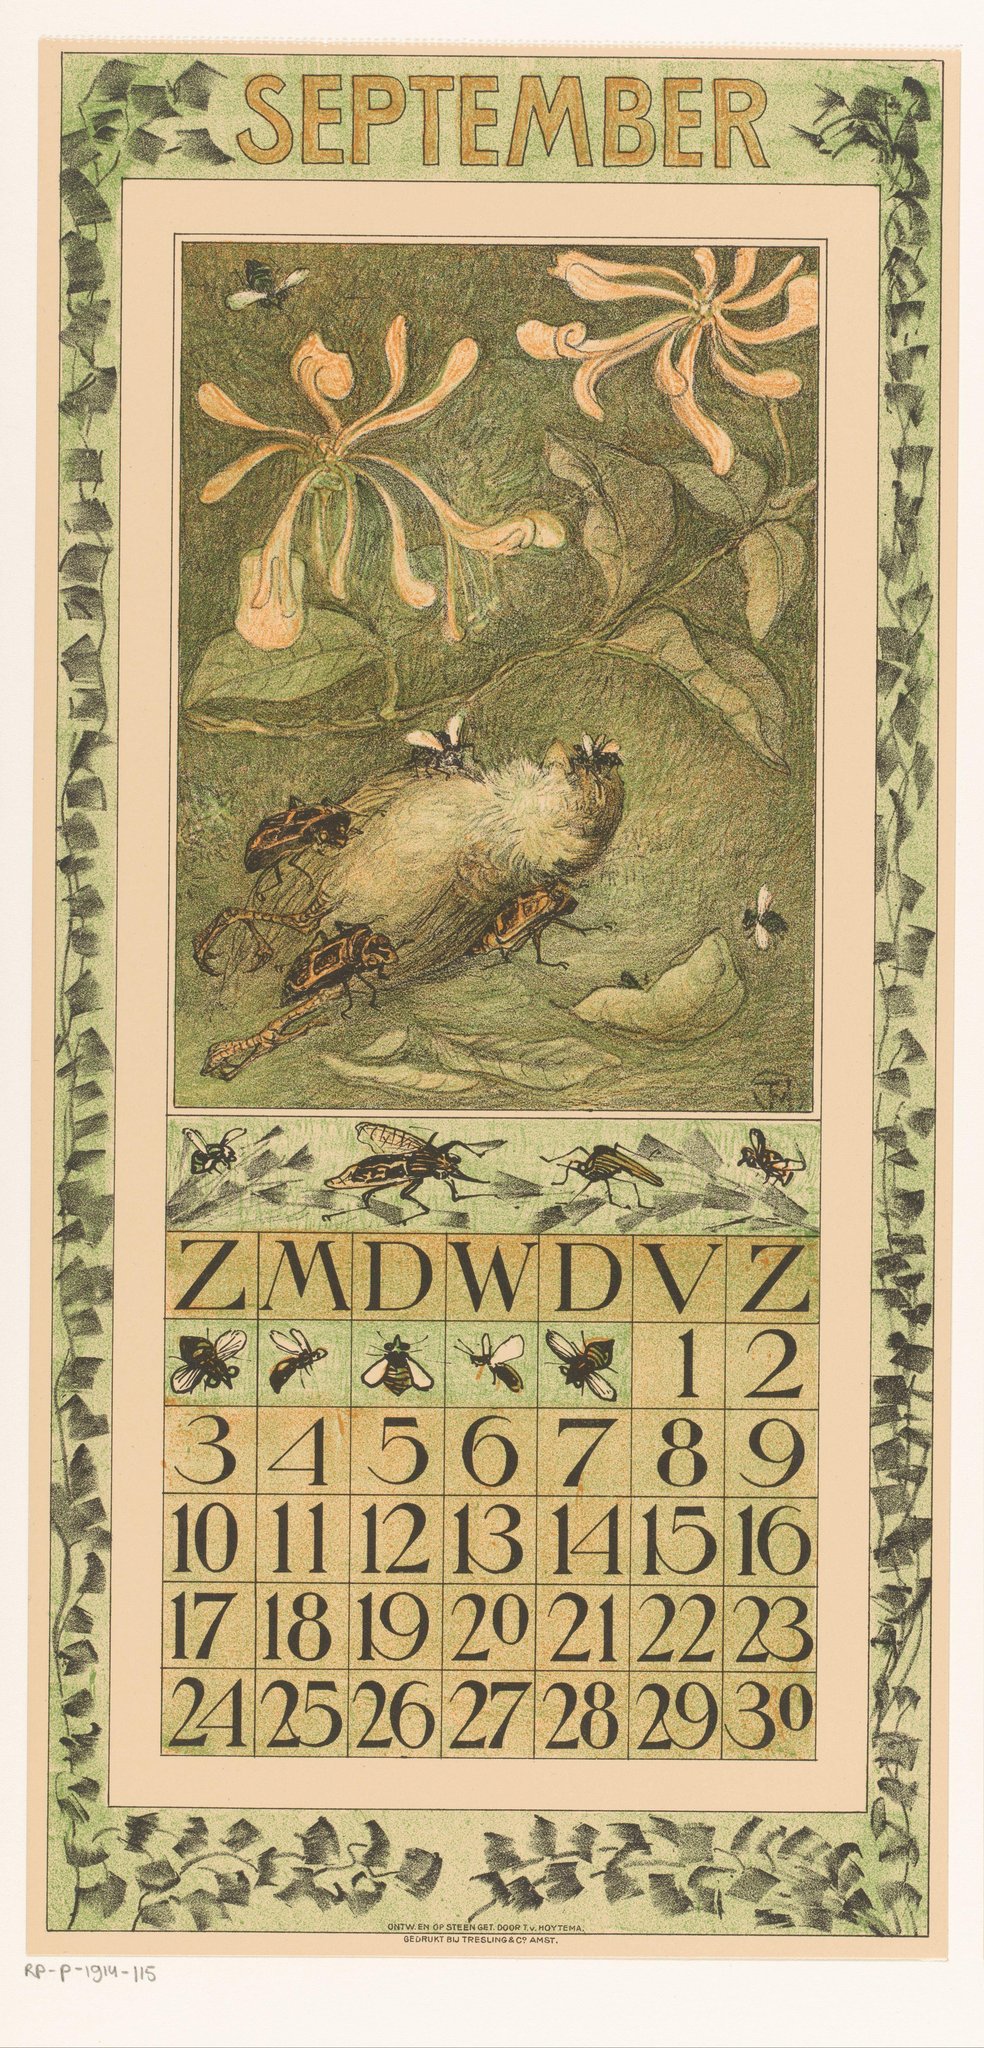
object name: calendar leaf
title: Kalender 1911 12 lithografien door Th. v. Hoytema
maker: theo van hoytema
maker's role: draughtsman, painter, print maker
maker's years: 1863-1917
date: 1910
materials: paper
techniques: lithograph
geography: amsterdam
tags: song-birds: sparrow (+ dying animal; death of animal; dead animal), insects, september ~ other concepts, insects: beetle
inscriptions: collector's mark: Lugt 2228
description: In de ornamentrand en het calendarium insecten. Bovenaan het blad een scheurlijn.